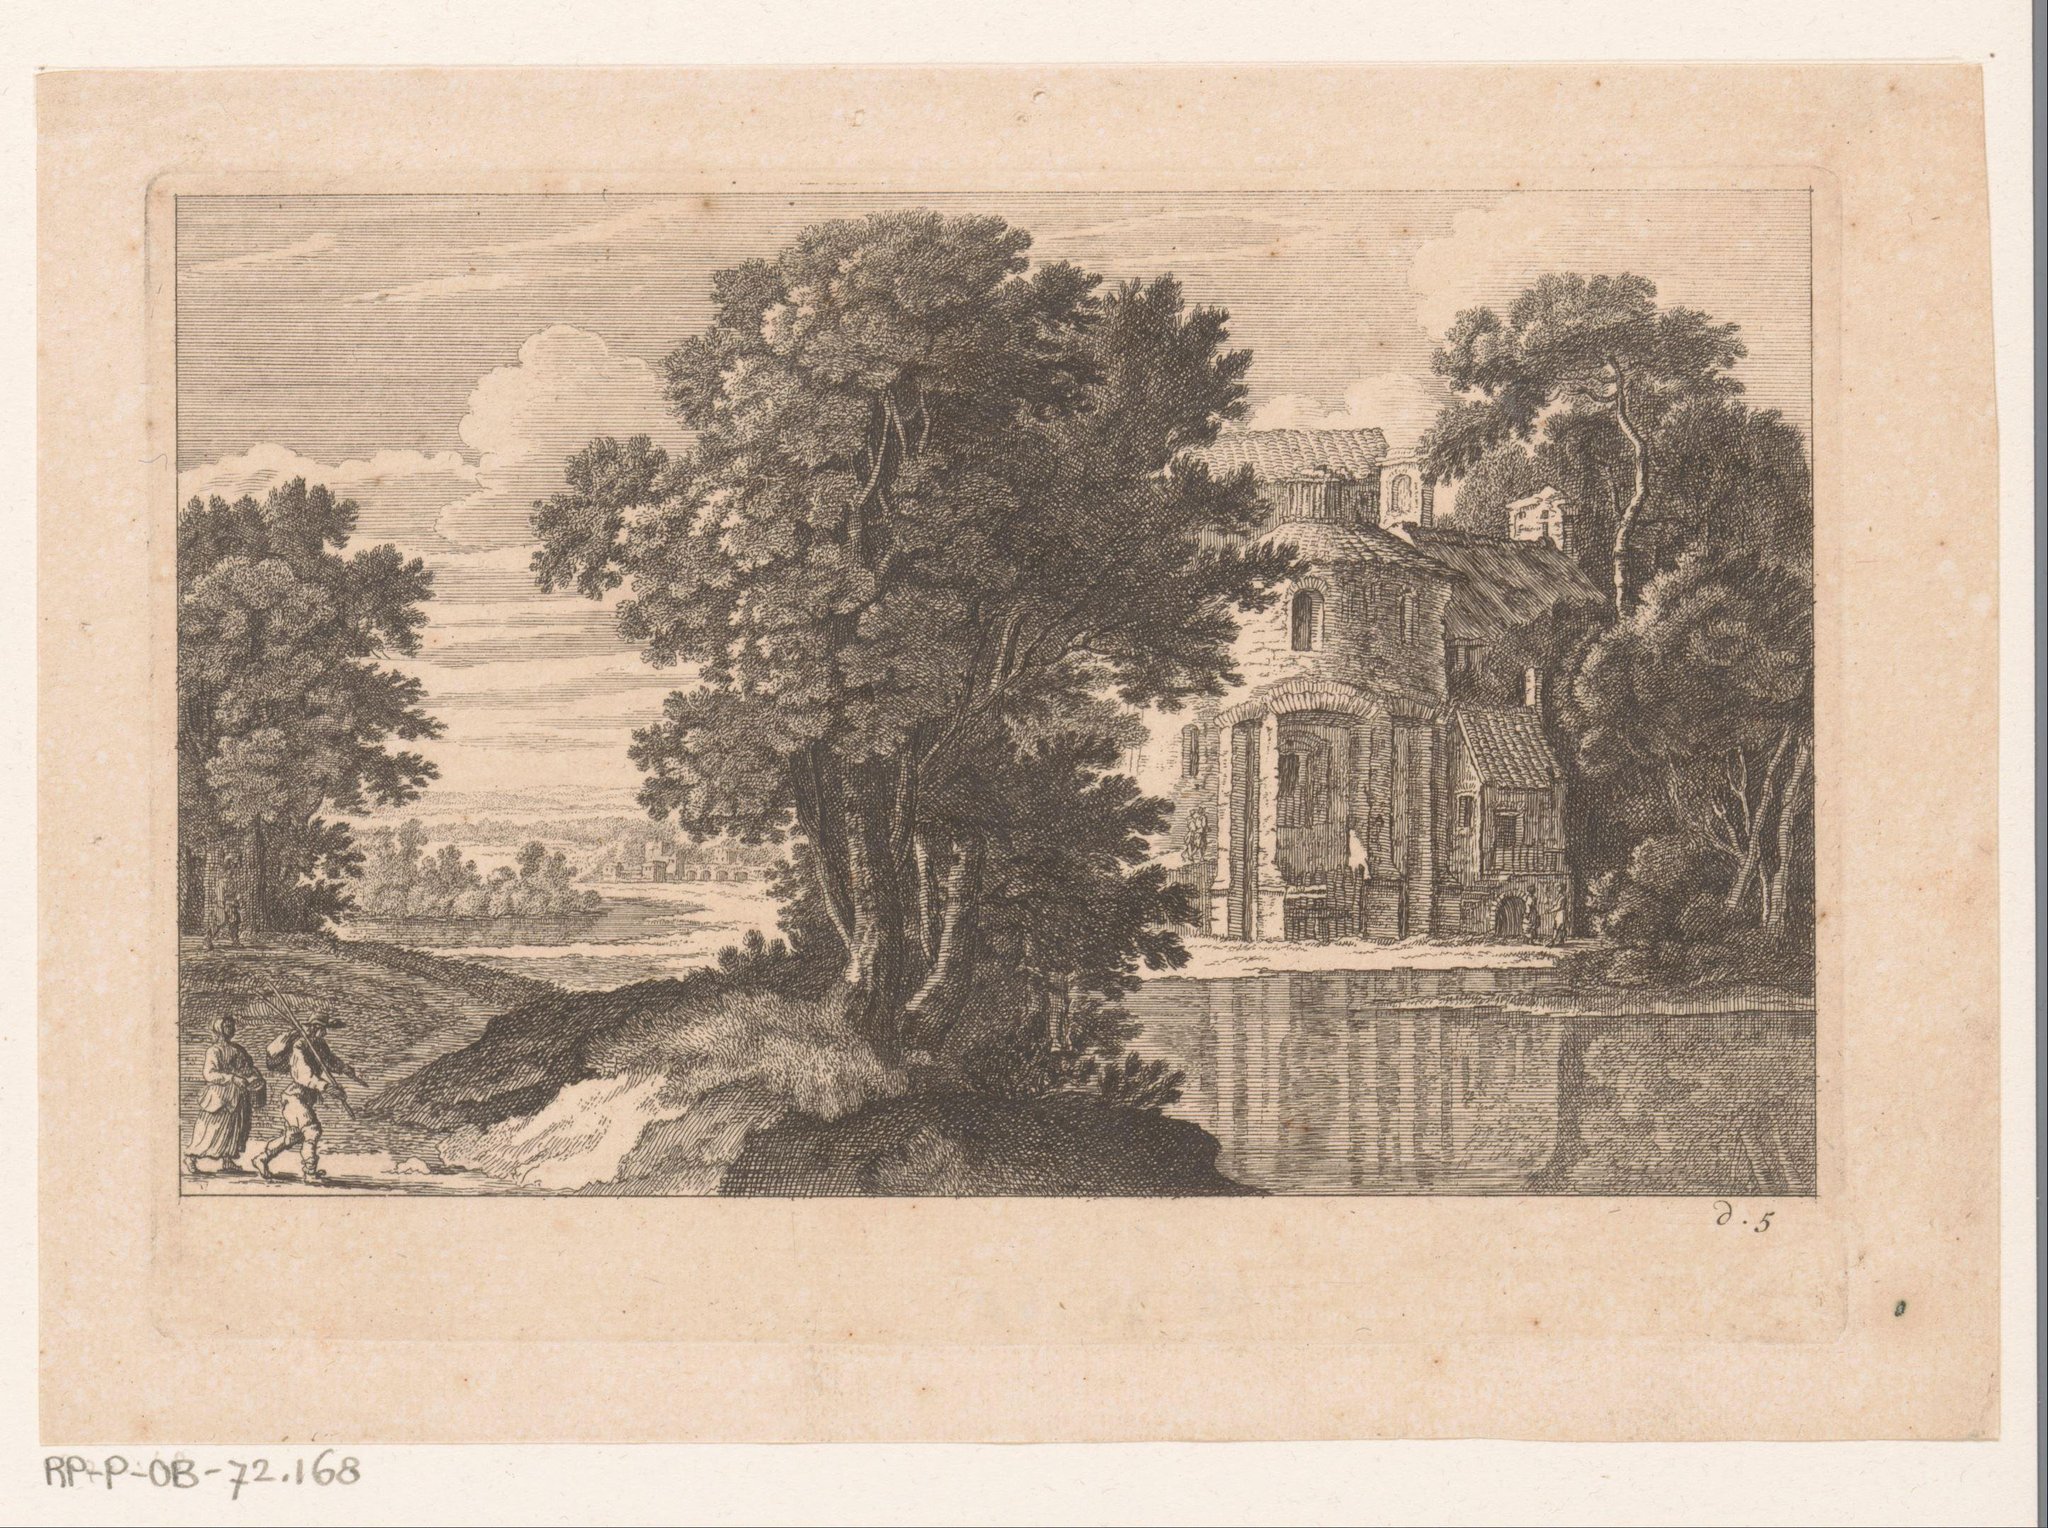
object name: print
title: Diverse landschappen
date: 1628-1679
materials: paper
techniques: etching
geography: amsterdam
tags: landscape with ruins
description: Prenten met het signatuur 'Perelle' kunnen zowel door vader Gabriel als door zonen Nicolas en Adam gemaakt zijn.